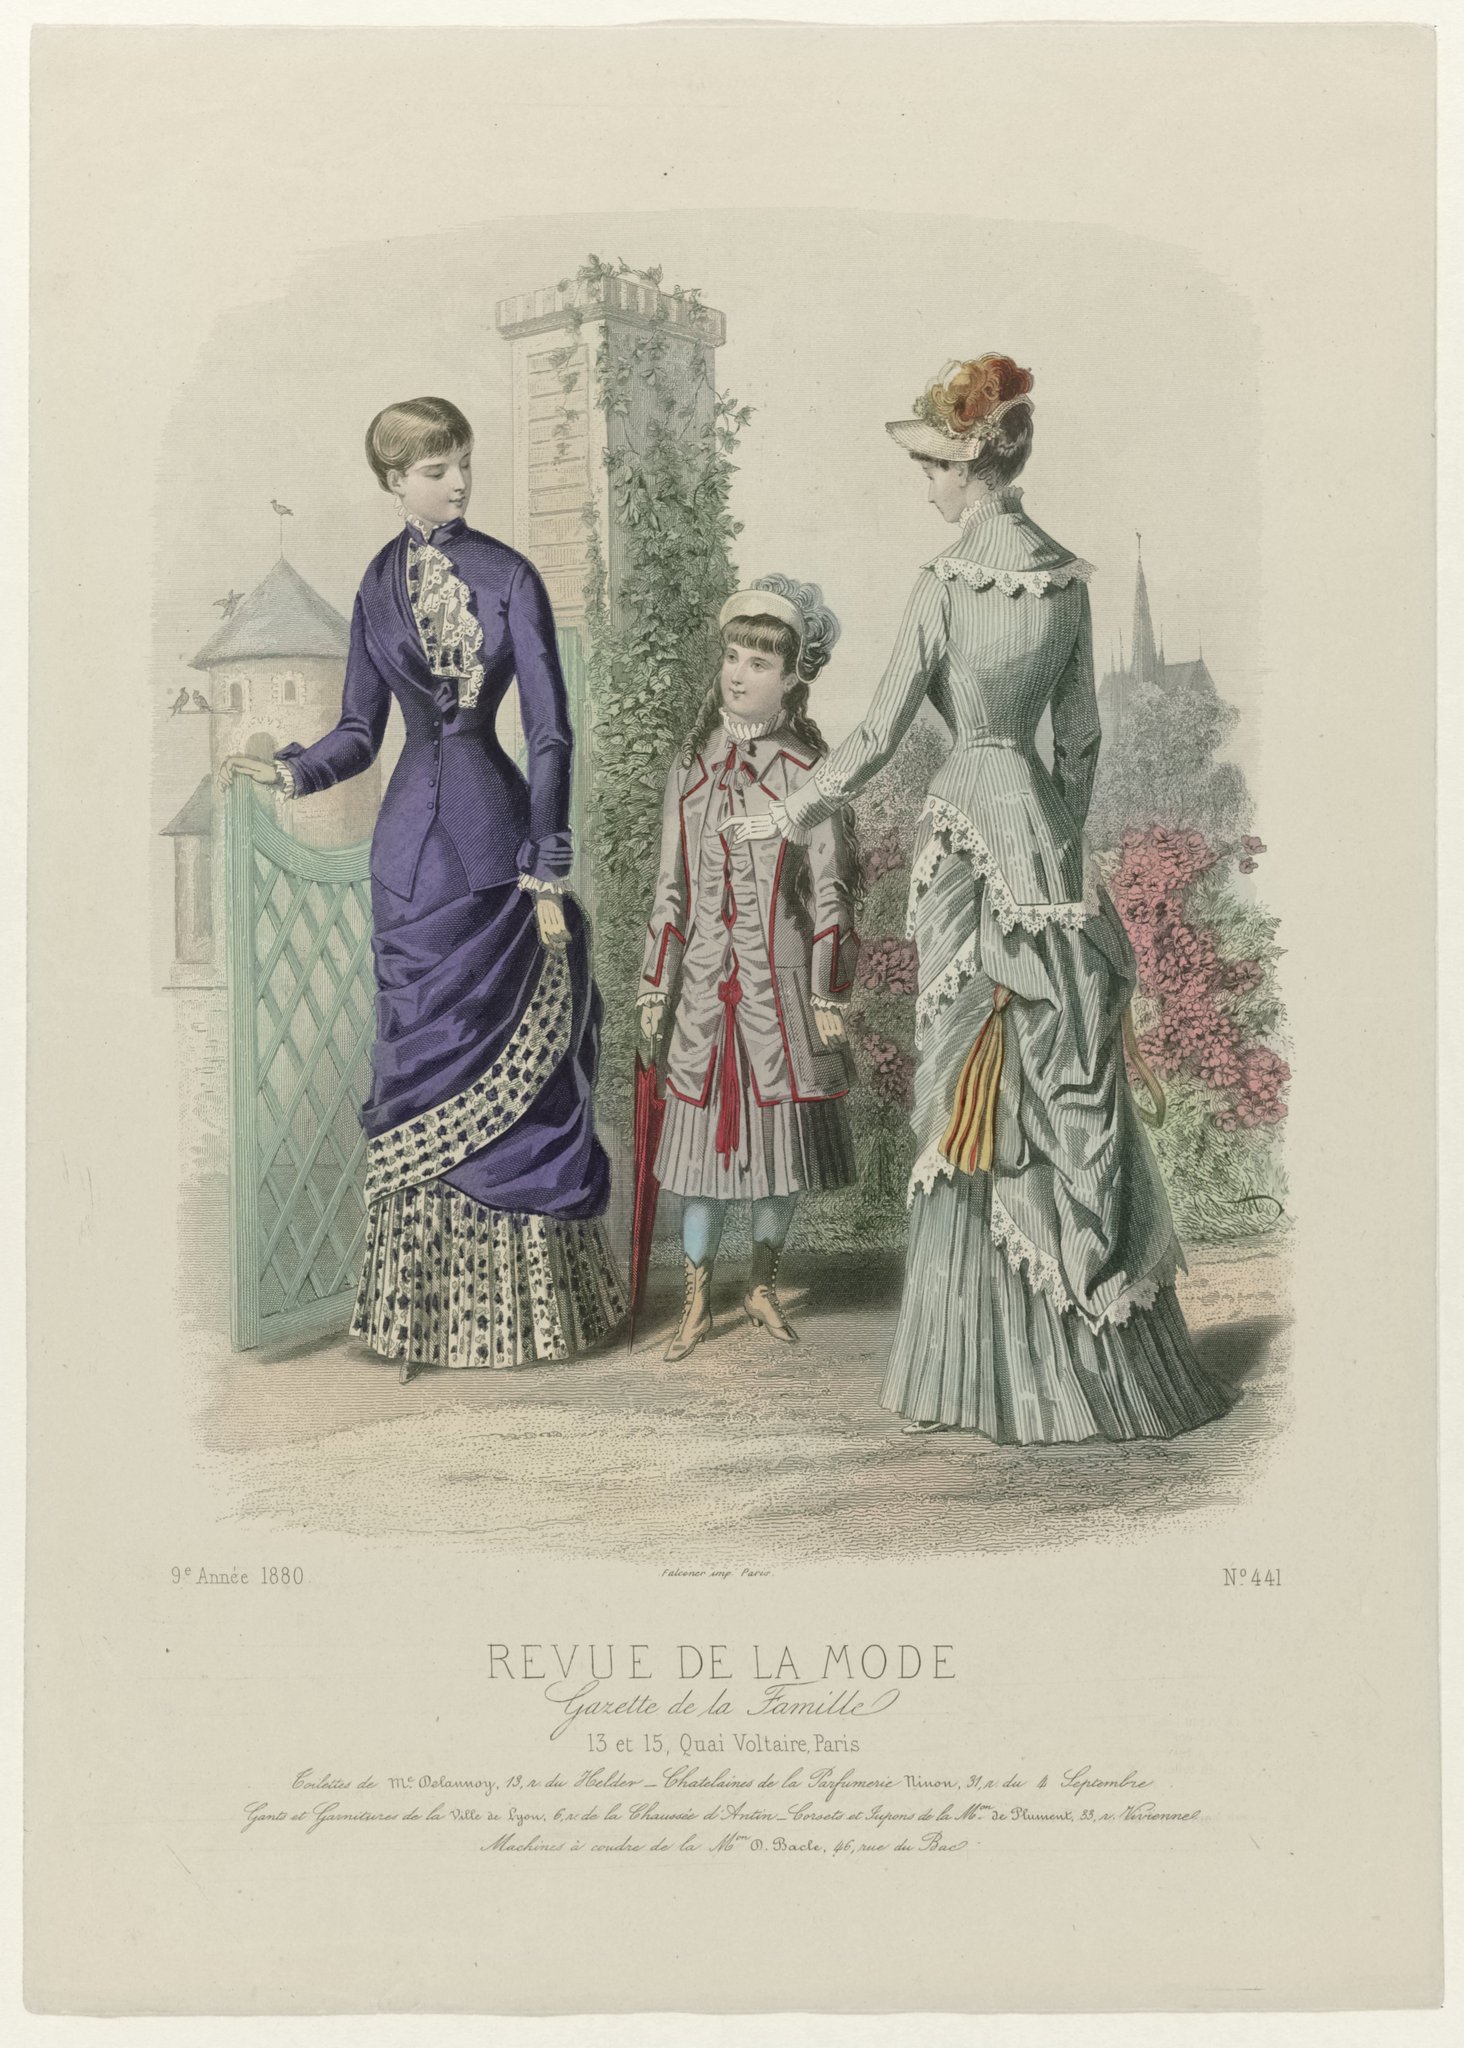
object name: fashion print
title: Revue de la Mode, Gazette de la Famille, dimanche 13 juin 1880, 9e année, No. 441: Toilettes de Me Delannoy (...)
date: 1880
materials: paper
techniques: engraving, hand coloring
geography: paris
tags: clothes, costume (+ girls' clothes), walking-stick, staff, cane (+ girls' clothes), lace (+ women's clothes), head-gear: hat (+ girls' clothes), border, ribbon, braid (+ girls' clothes), head-gear (straw hat) (+ women's clothes), neck-gear: collar (+ women's clothes), fashion plates, dress, gown (+ women's clothes), dove-cote, gate, entrance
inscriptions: title: ‘REVUE DE LA MODE / Gazette de la Famille’, caption: ‘Toilettes e M.e Delannoy, 13, r. du Helder_ Chatelaines de la Parfumerie Ninon, 31, r. du 4 Septembre Gants et Garnitures de la Ville de Lyon, 6, r. de la Chaussée d'Antin _ Corsets et Jupons de la M.on de Plument, 33, r. Vivienne. Machines à coudres de la M.on D. Bacle, 46, rue du Bac.’, address: ‘13 et 15, Quai Voltaire, Paris’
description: Twee vrouwen en een meisje bij het hek van een tuin, gekleed in japionnen van Delannoy. Links: korte japon van paarse 'surah' en 'surah pompadour' met paarse bloemen, voor een jonge vrouw Midden: meisjeskostuum van grijze 'surah', gegarneerd met rood boordsel. Witte strohoed met blauwe veren. Rechts: japon voor een jonge vrouw van gestreepte batist in groen en wit. 'Corsage habit' met brede platte kraag gegarneerd met wit kant. Onder de afbeelding enkele regels reclametekst voor verschillende producten. Prent uit het modetijdschrift Revue de la Mode (1872-1913). Uitgebreide beschrijving van de kleding op pagina 197 "PLANCHE COLORIÉE"